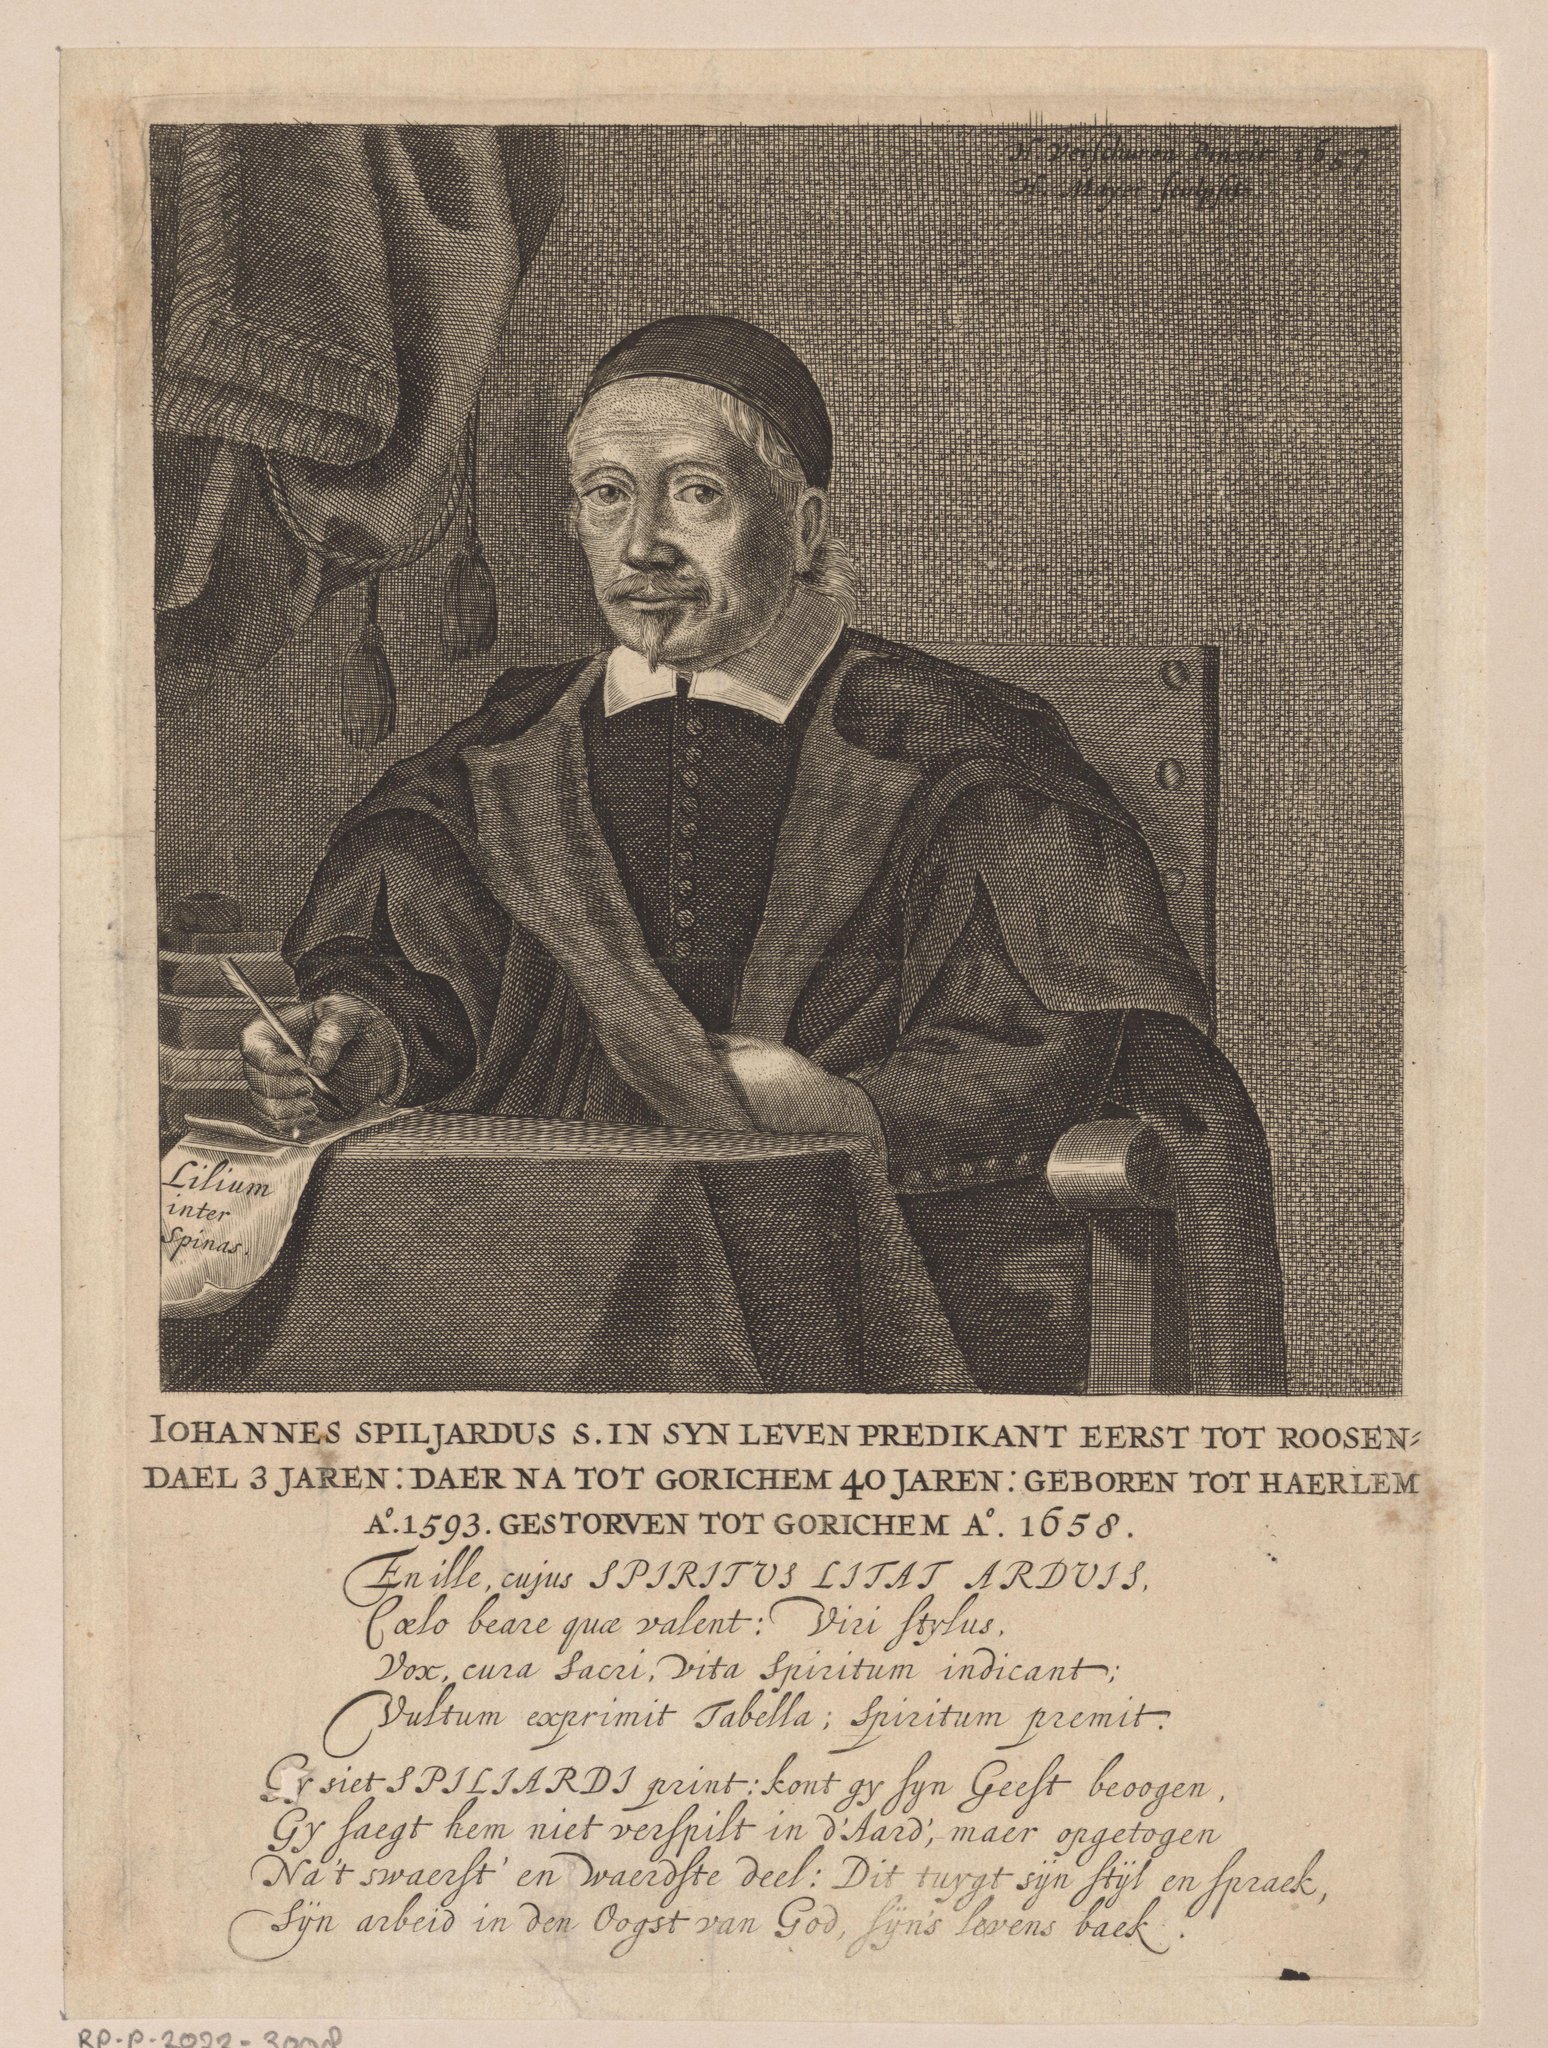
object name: print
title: Portret van Johannes Spiljardus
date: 1658-1699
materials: paper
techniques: engraving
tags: historical persons, functionaries and dignitaries (with name) ~ episcopal protestant churches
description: Met vierregelig onderschrift in het Latijn en in het Nederlands.